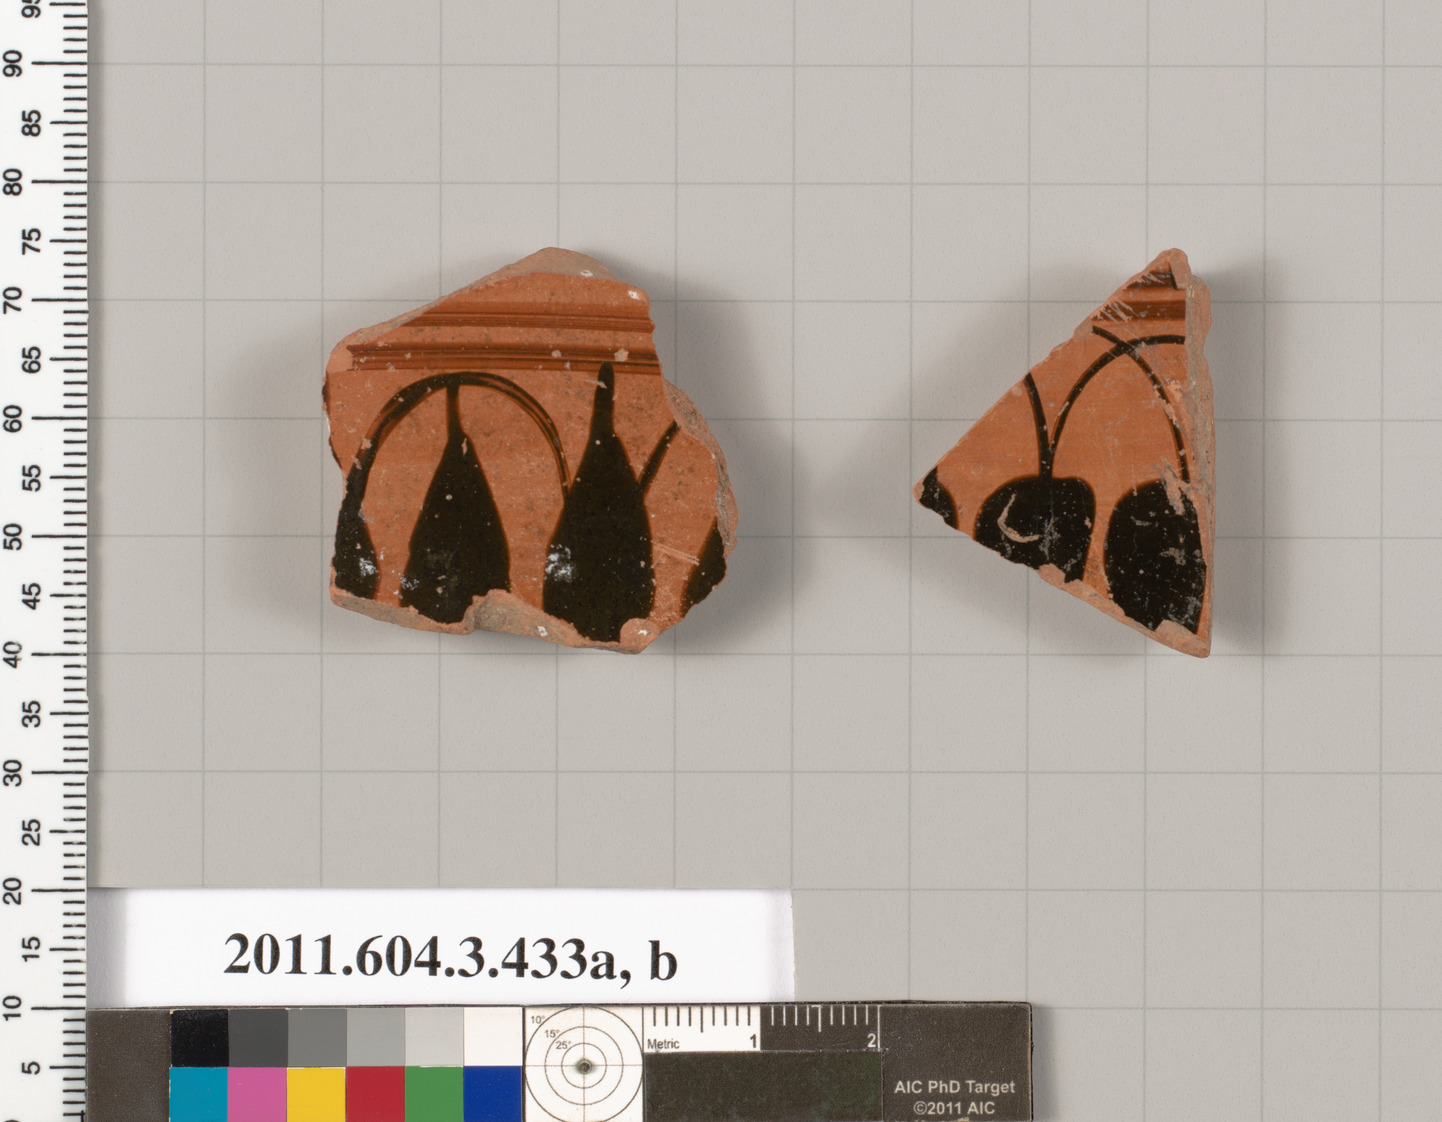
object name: neck amphora fragment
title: Terracotta fragments of neck-amphorae (jars)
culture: greek, attic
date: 520-510 BCE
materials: terracotta